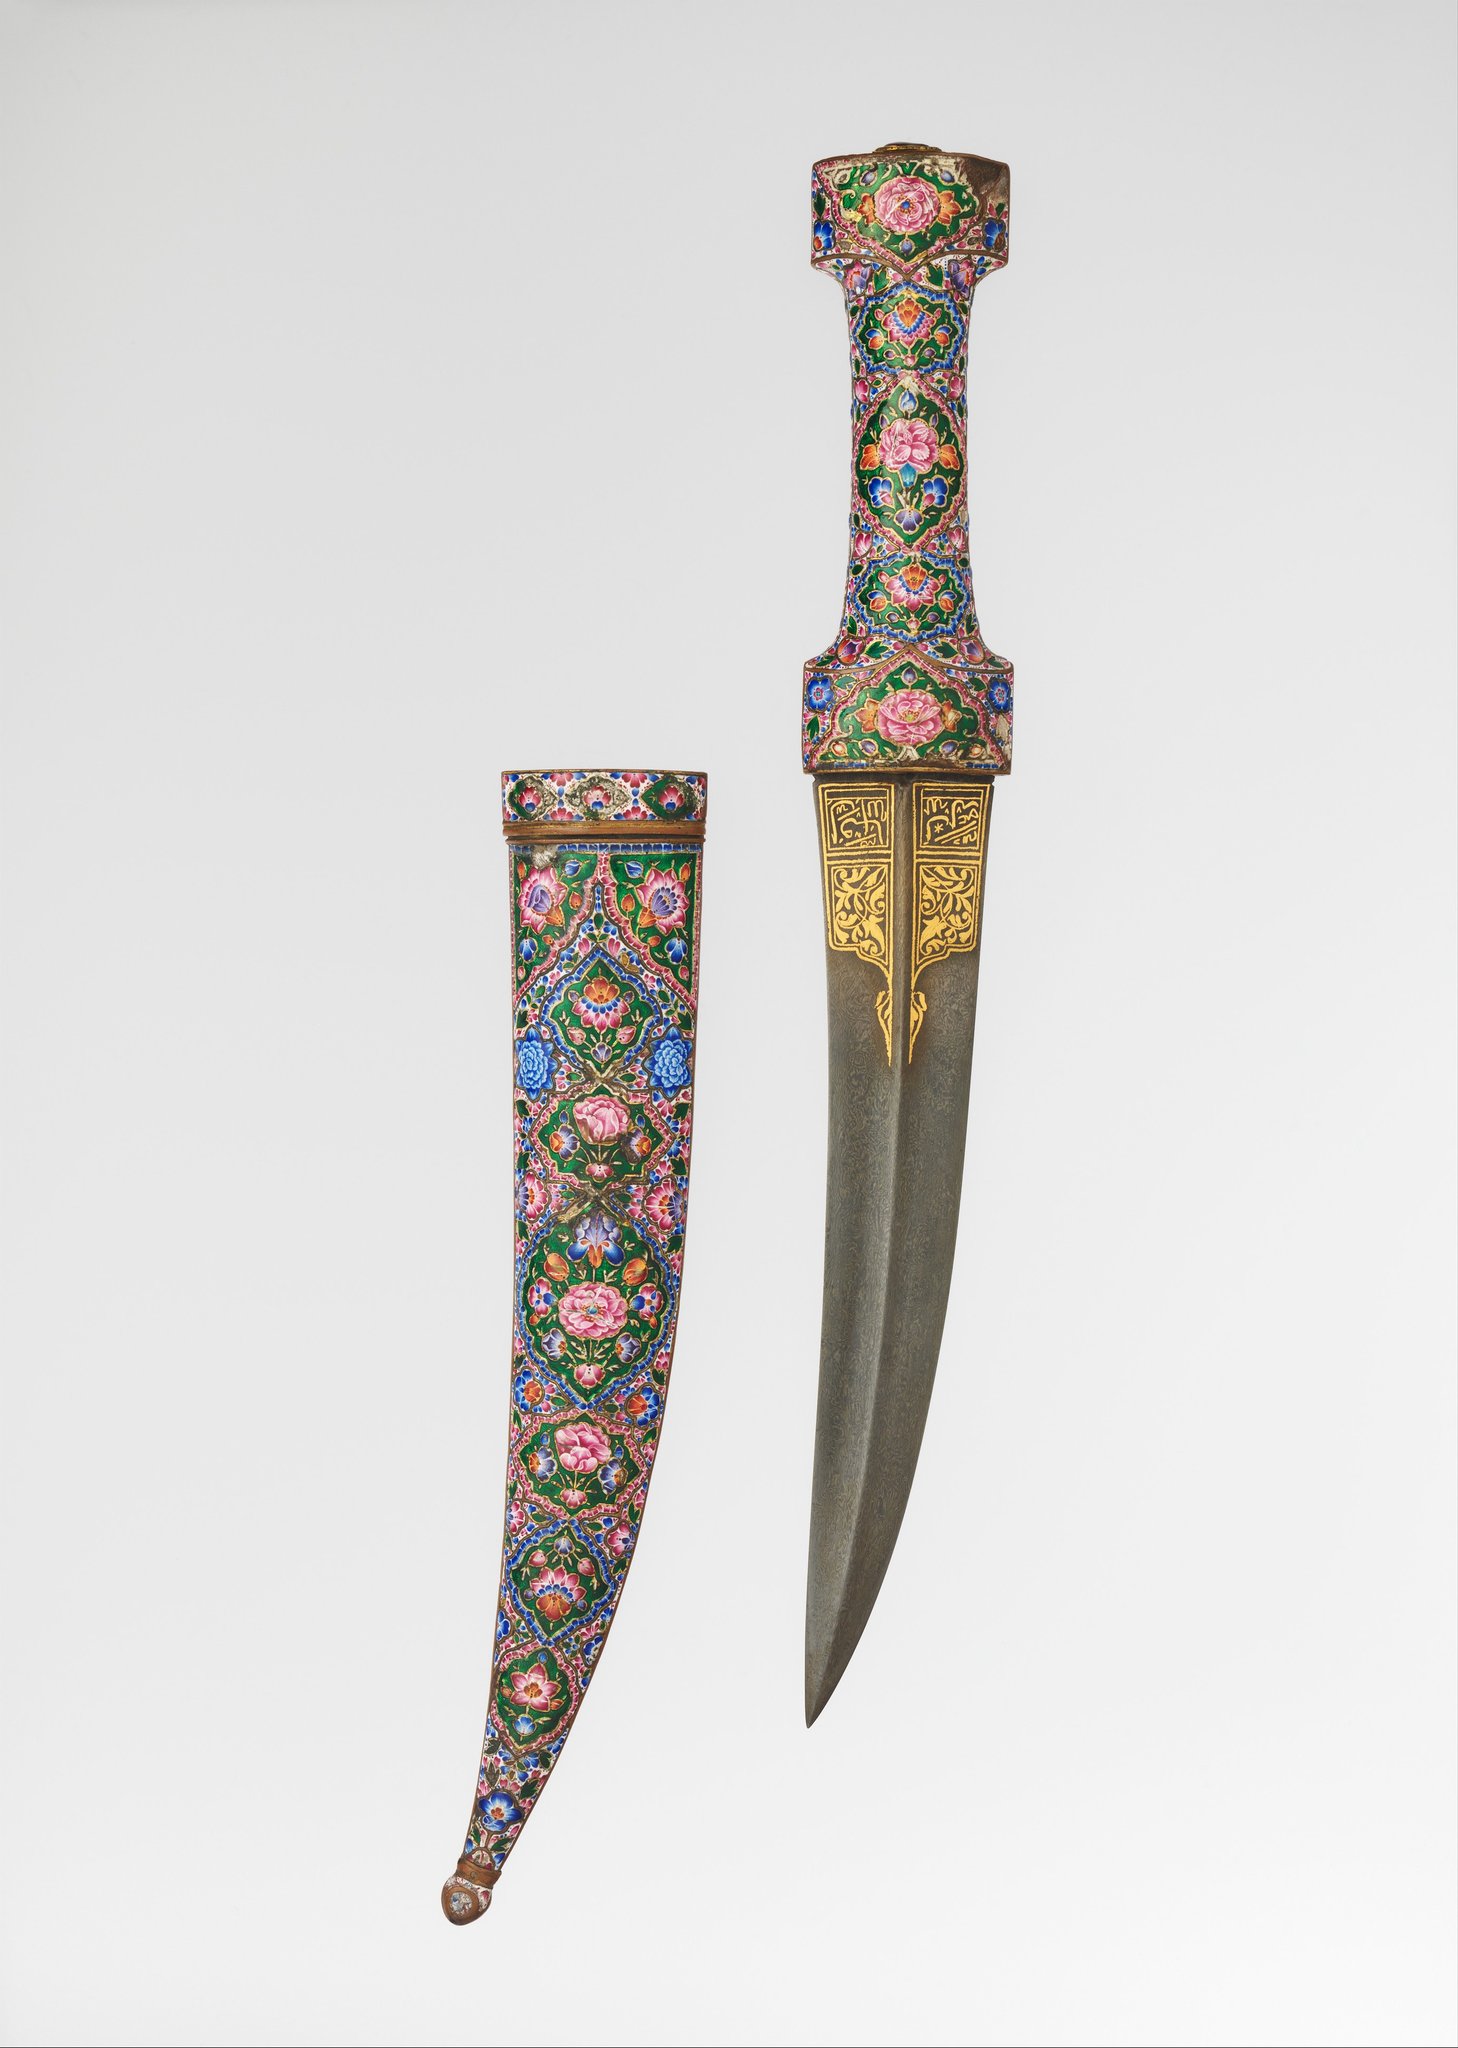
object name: dagger with sheath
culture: iranian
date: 1767-1833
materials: copper alloy, enamel, glass, gold, steel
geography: iran